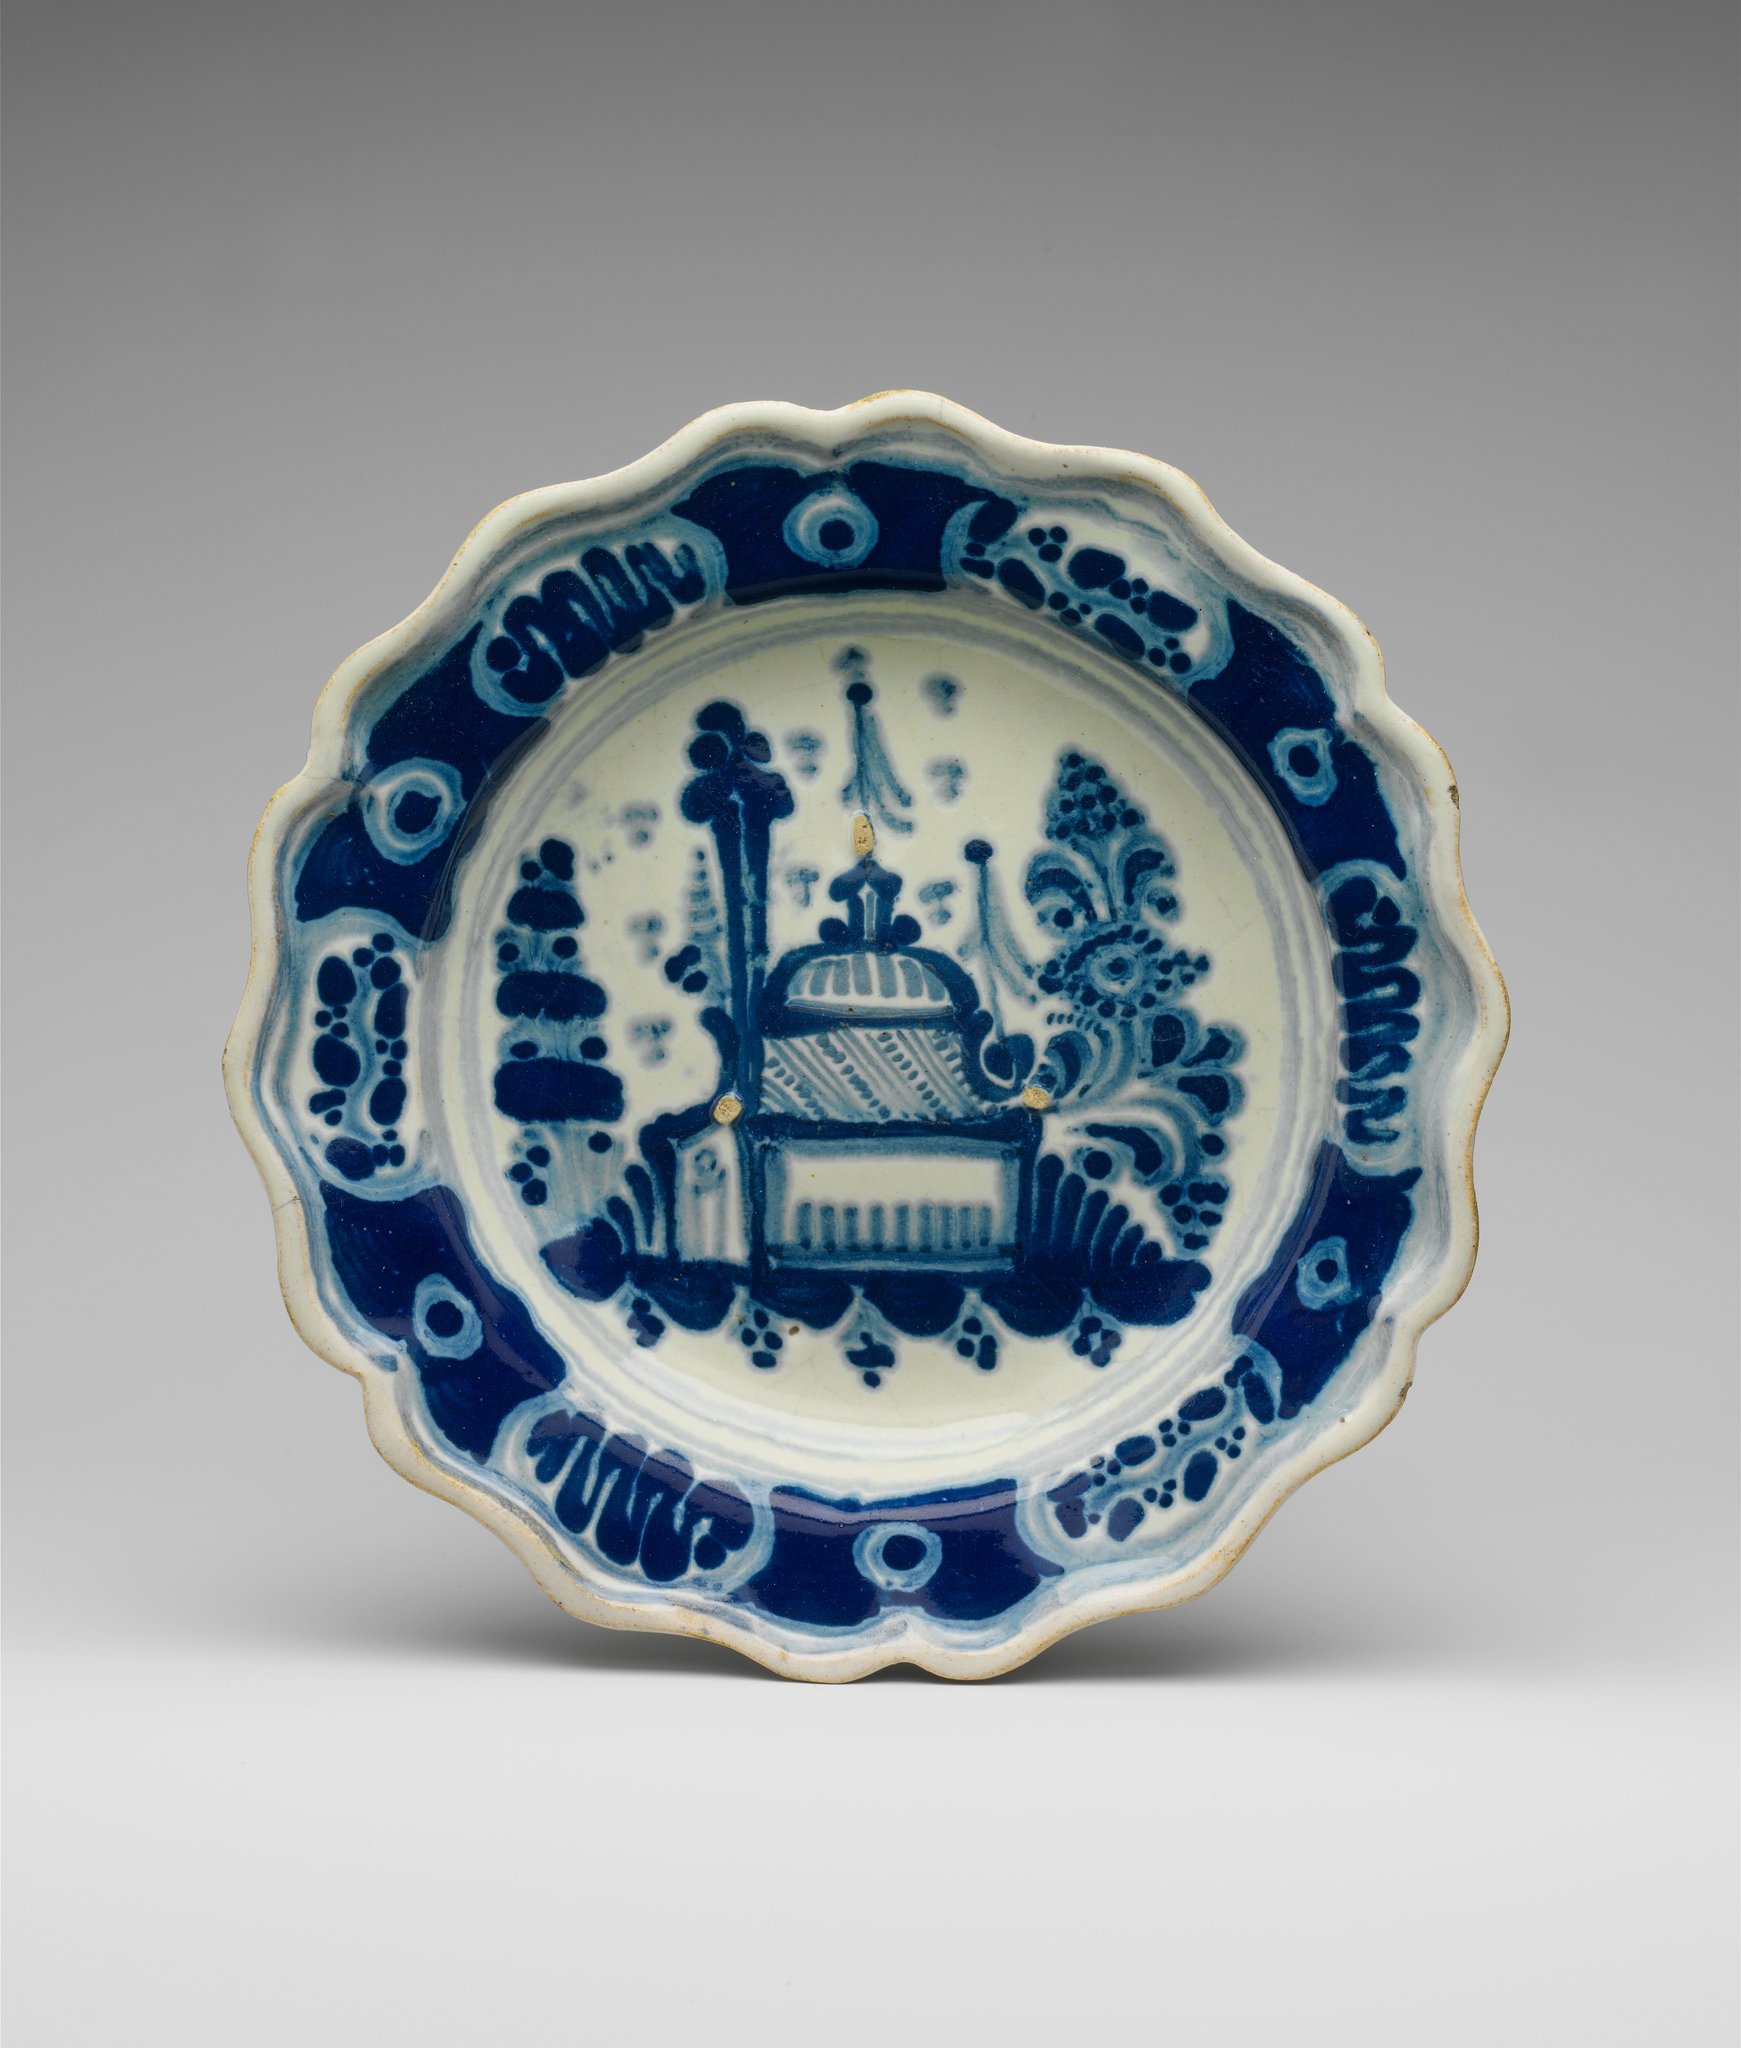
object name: plate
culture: mexican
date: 1800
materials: earthenware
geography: mexico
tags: buildings